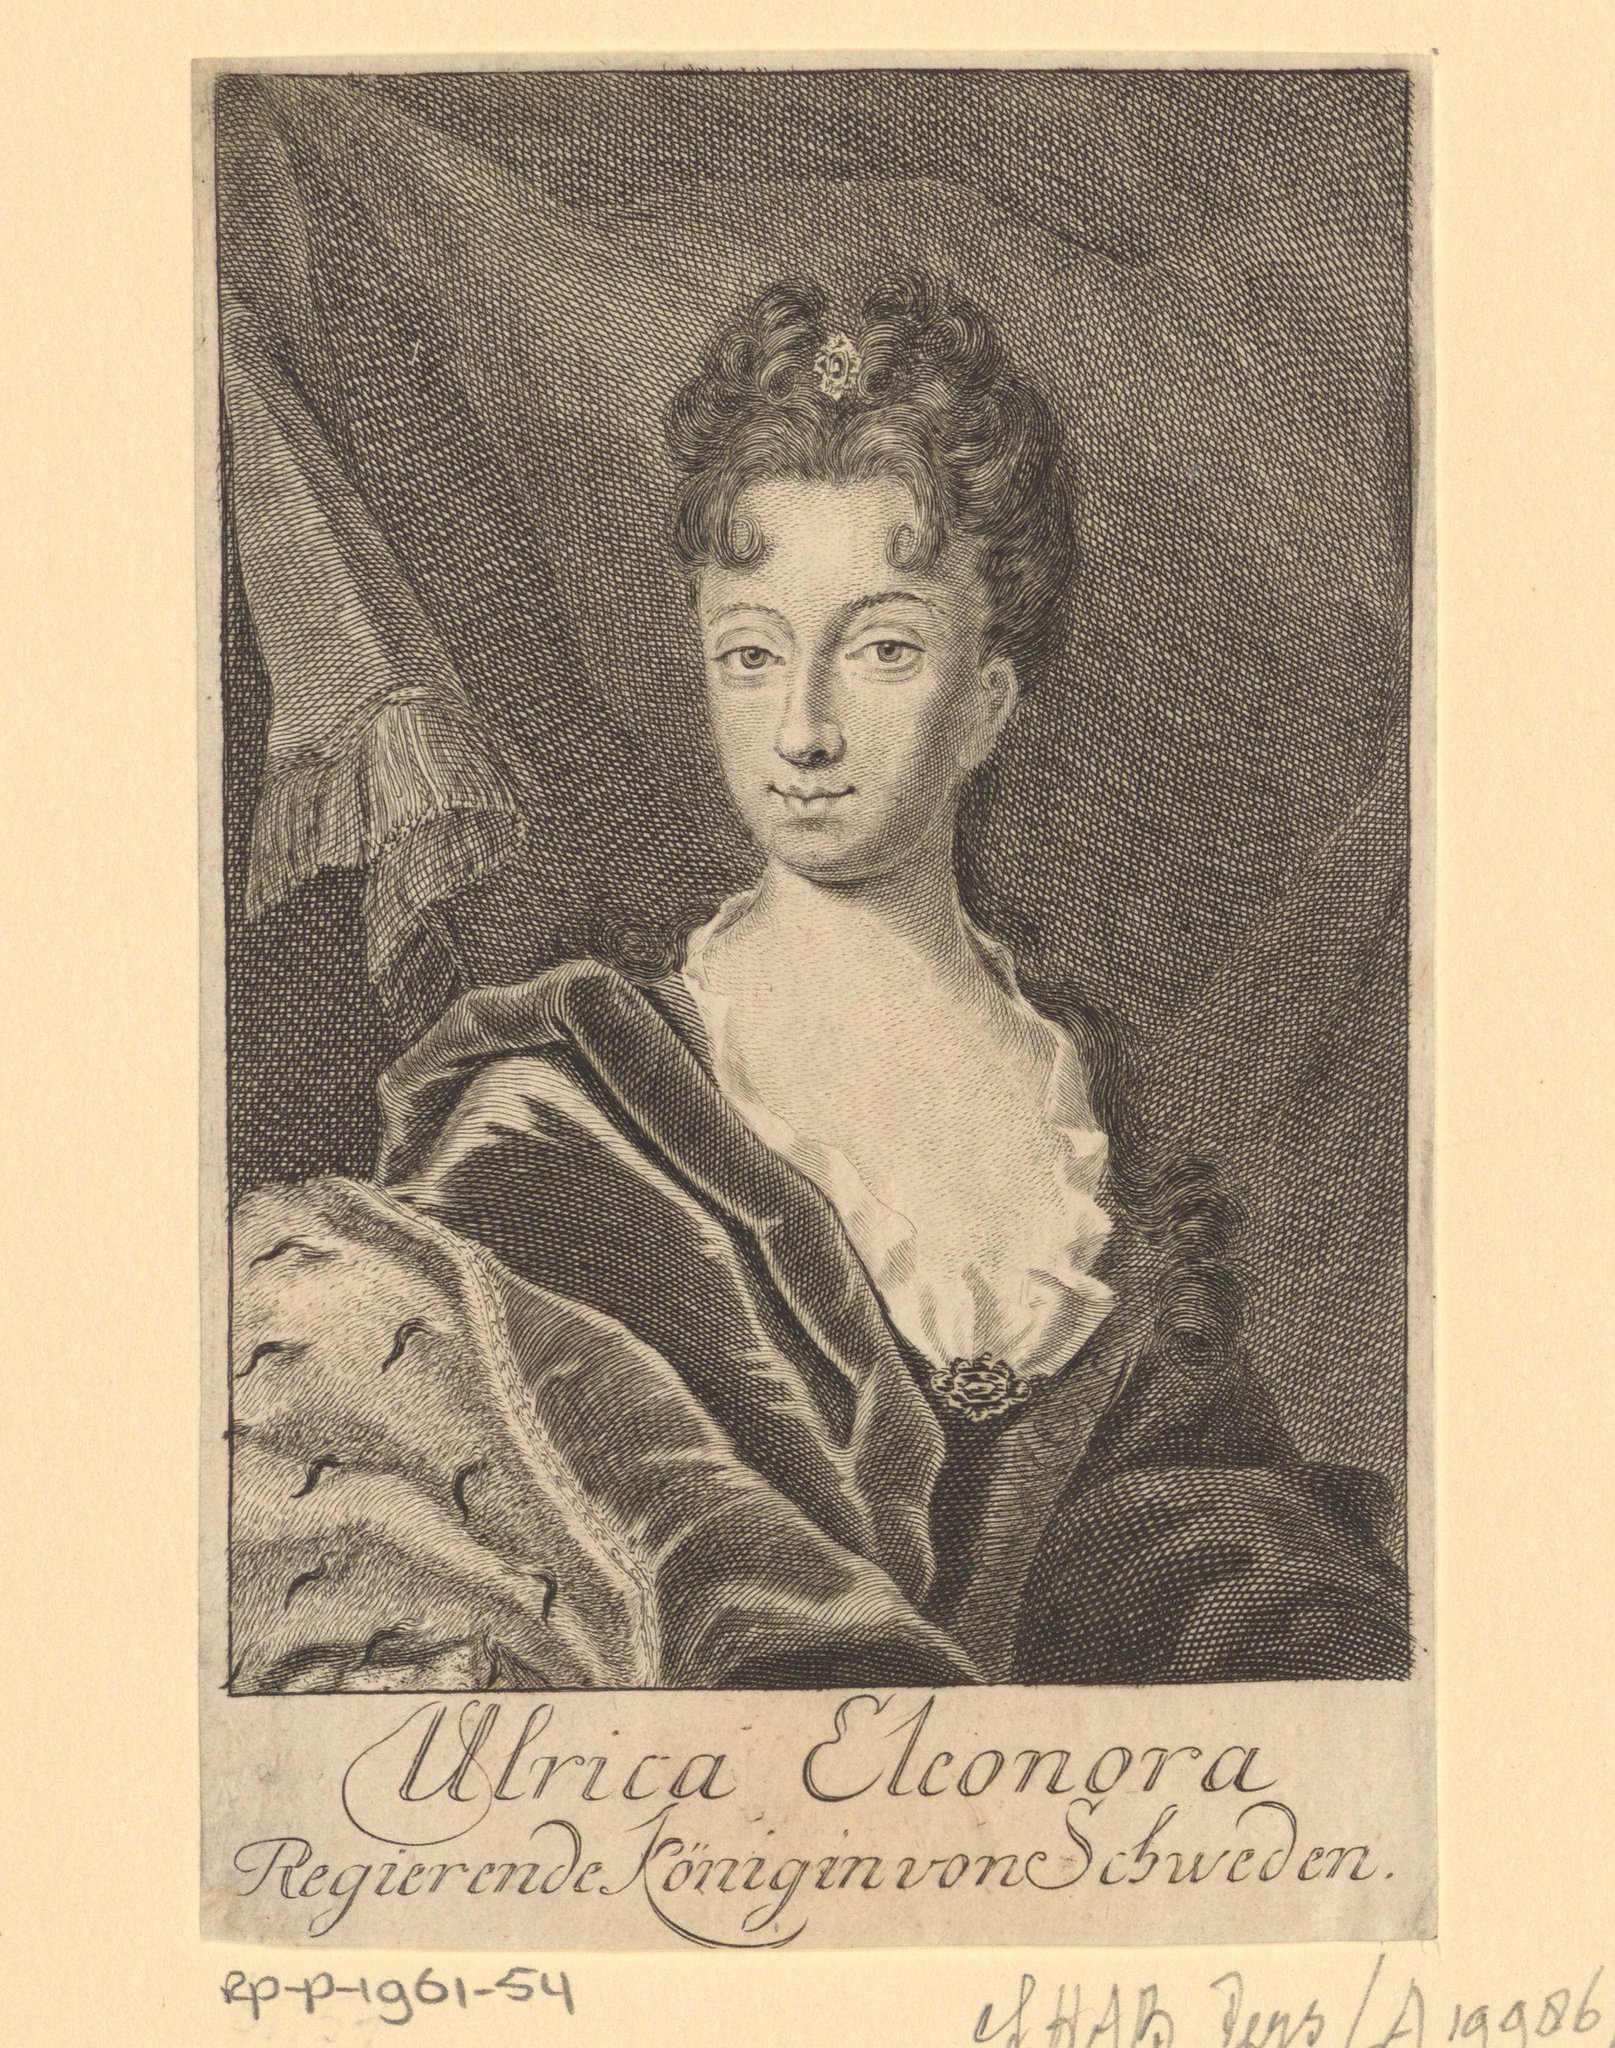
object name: print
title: Portret van Ulrika Eleonora van Zweden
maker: Anonymous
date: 1718-1720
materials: paper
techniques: engraving, etching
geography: germany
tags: historical persons - bb - woman, queen